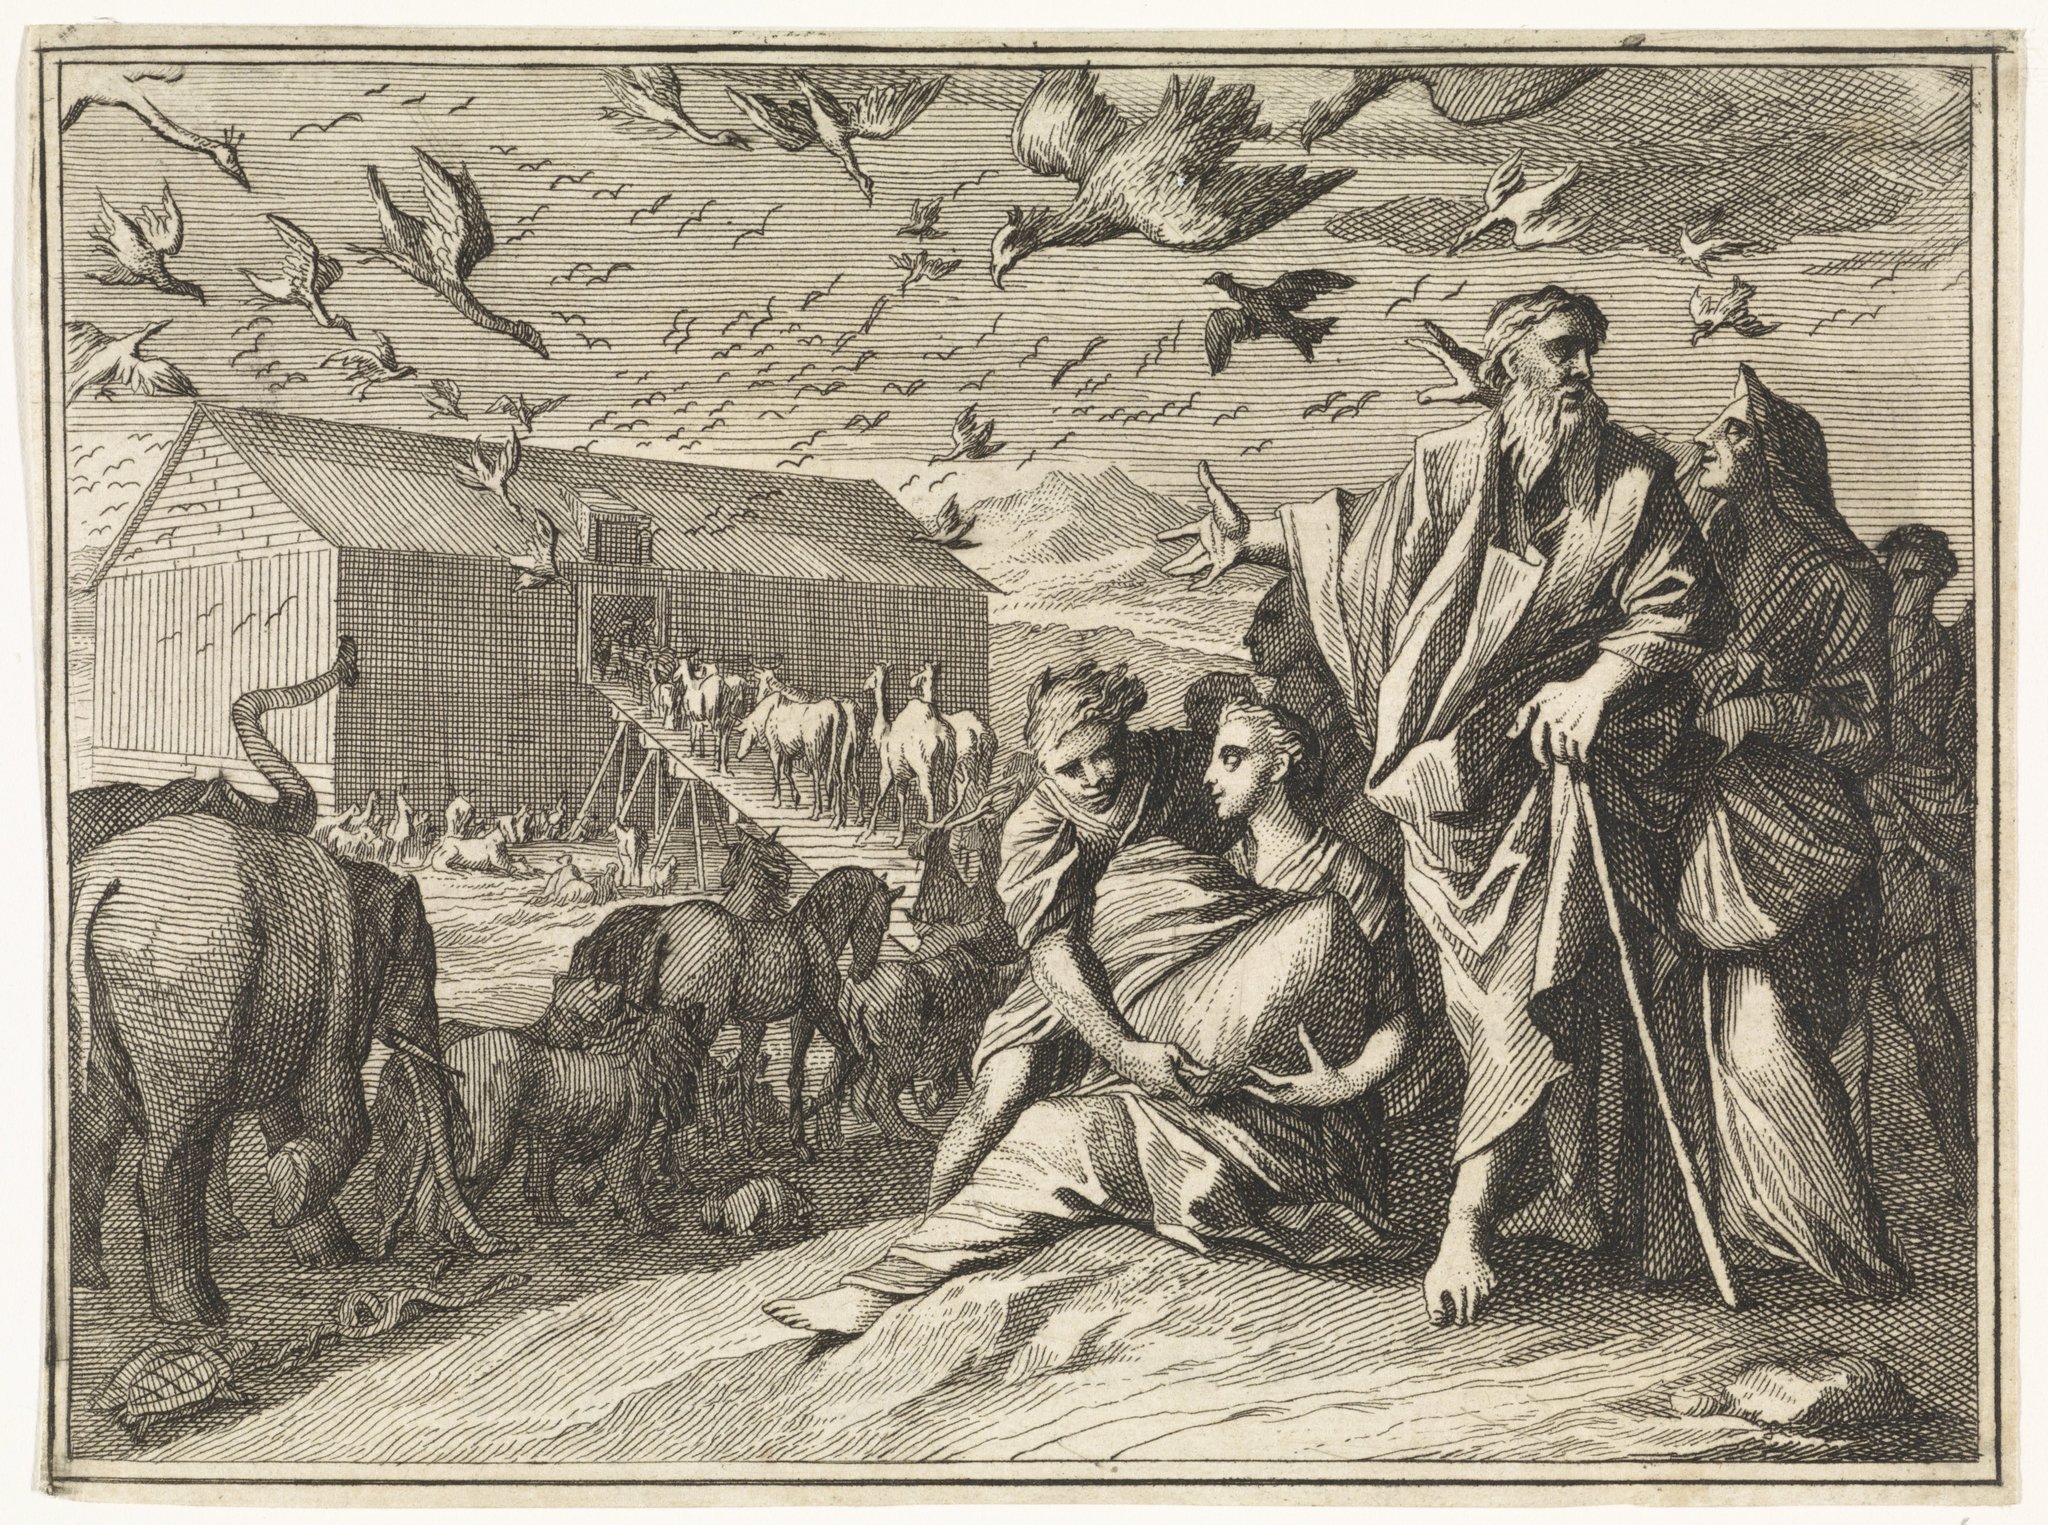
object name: print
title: Noach en zijn gezin begeven zich richting de ark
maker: caspar luyken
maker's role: draughtsman, print maker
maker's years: 1672-1708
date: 1712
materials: paper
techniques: etching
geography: amsterdam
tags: the embarkation of the ark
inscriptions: number: ‘12’, collector's mark: Lugt 2228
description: Illustratie uit: Luyken, Jan. De schriftuurlyke geschiedenissen en gelykenissen van het Oude en Nieuwe Verbond, 2 delen. Amsterdam: Wed. Pieter Arentsz II en Cornelis van der Sys, 1712, dl. I.